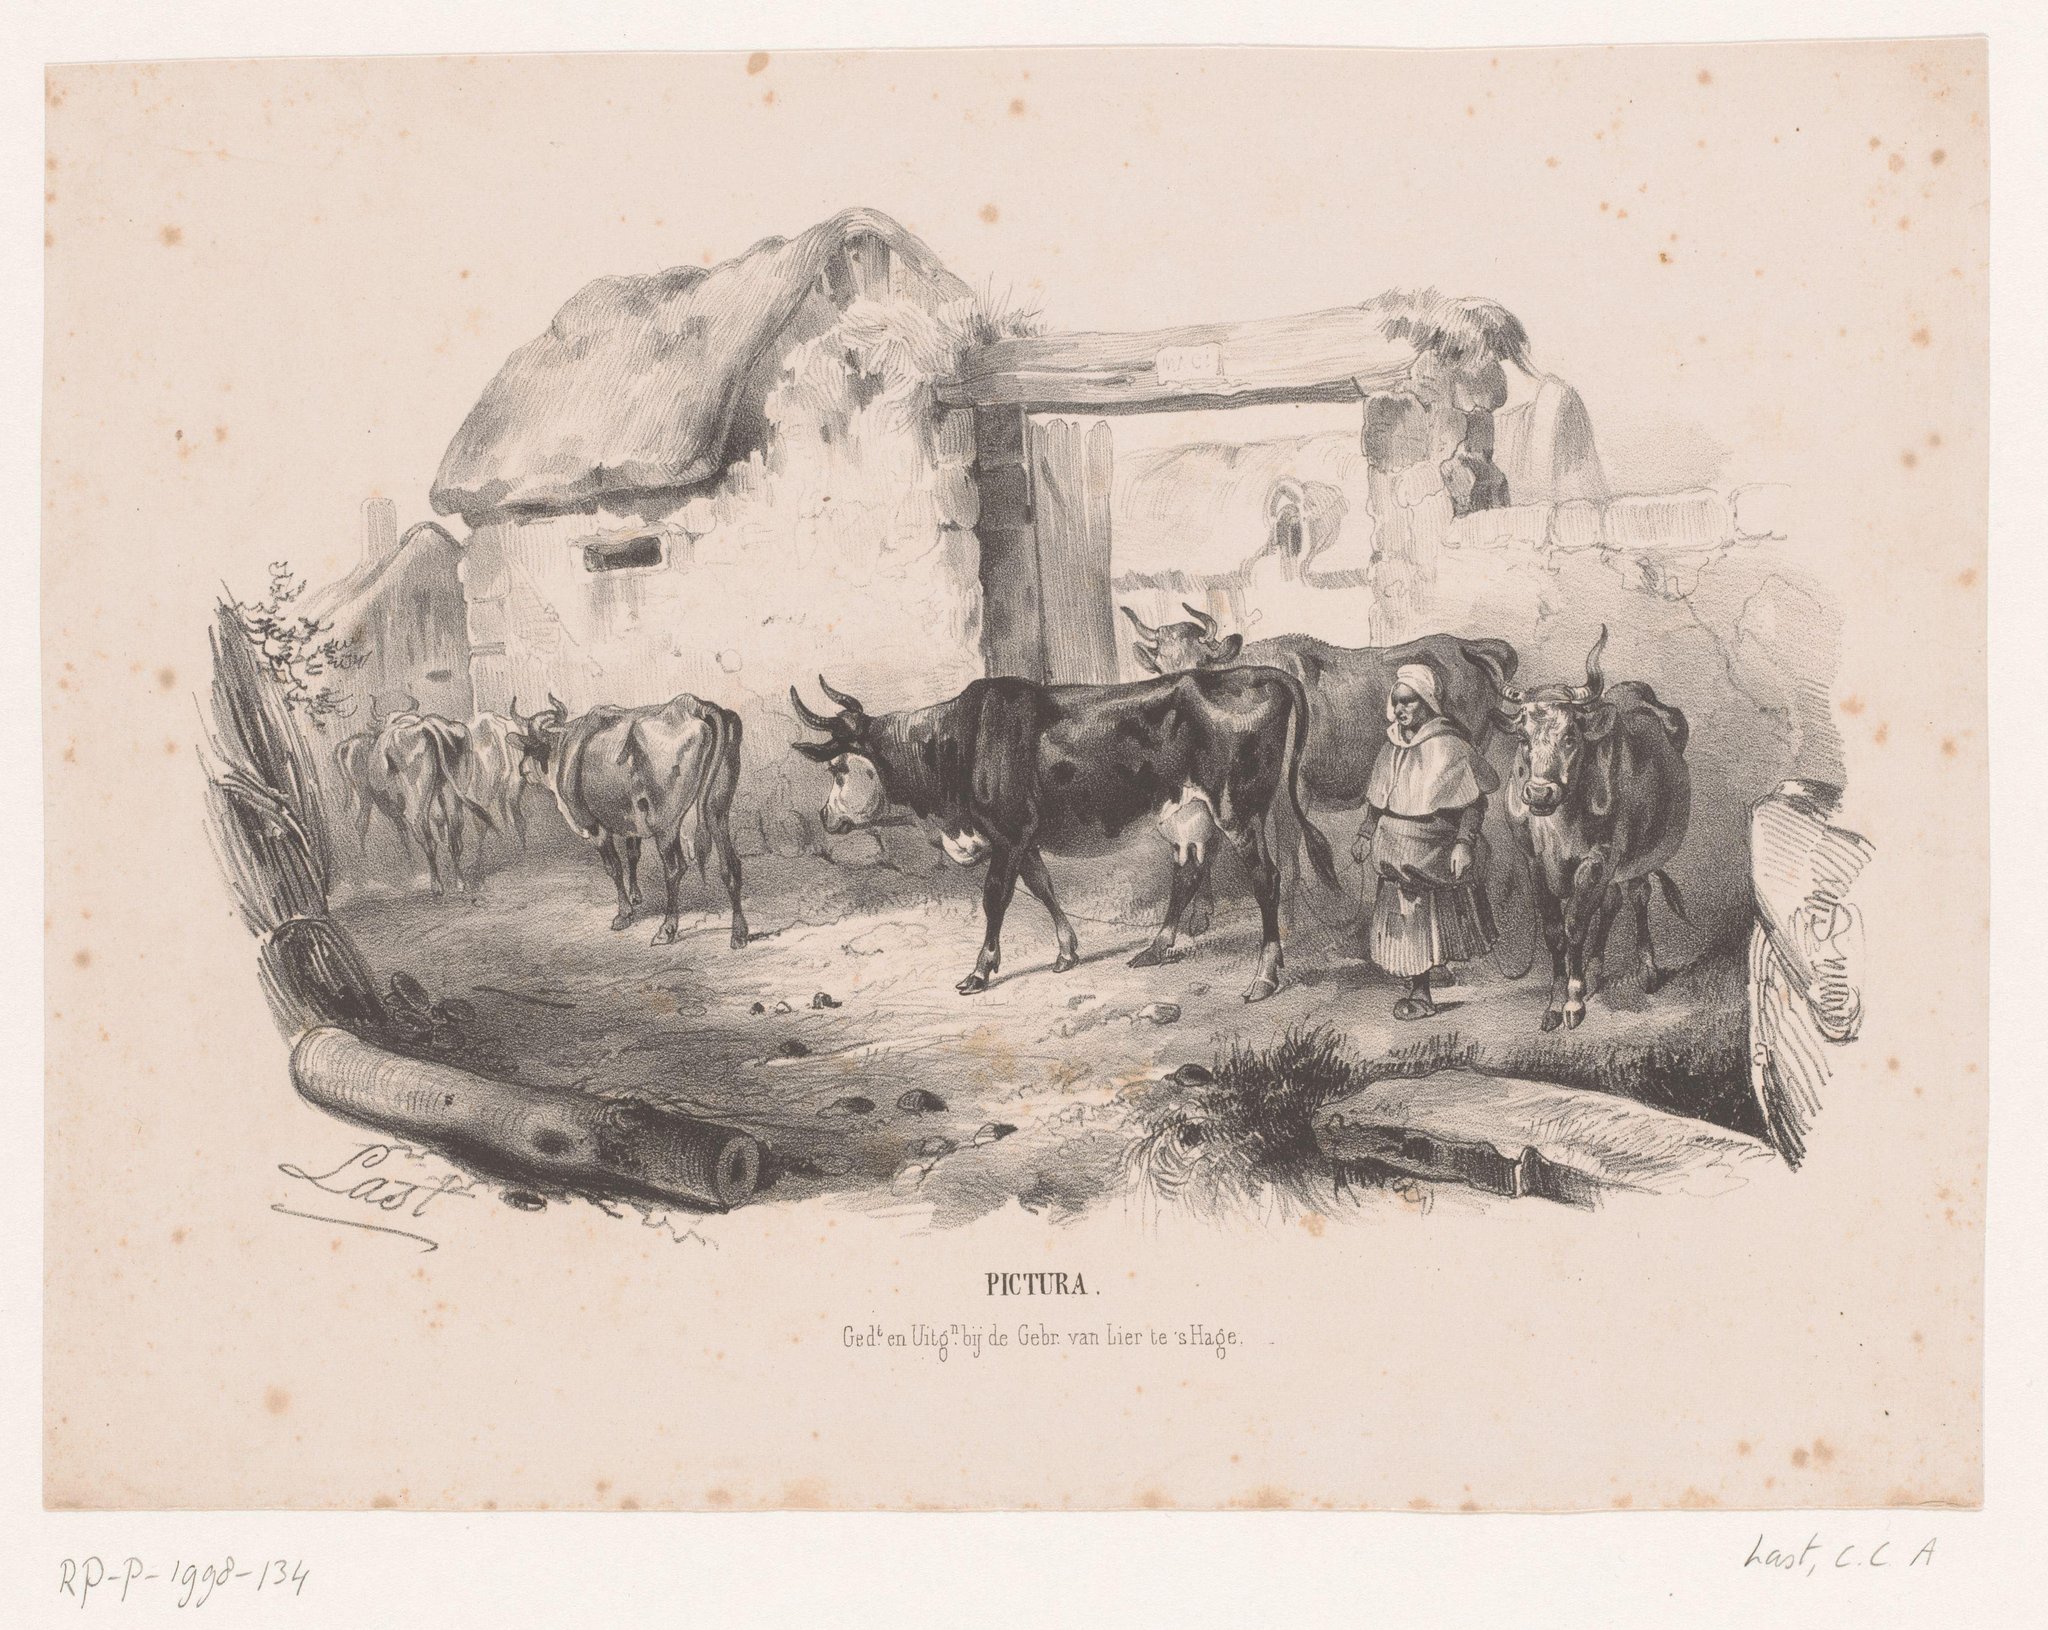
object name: print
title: Kudde koeien met herderin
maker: carel christiaan antony last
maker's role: print maker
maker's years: 1808-1876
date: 1834-1876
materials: paper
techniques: lithography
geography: the hague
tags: herding, herdsman, herdswoman, shepherd, shepherdess, cowherd, etc., herd, flock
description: Voor de poort van een boerderij staat boerin bij een kudde koeien.